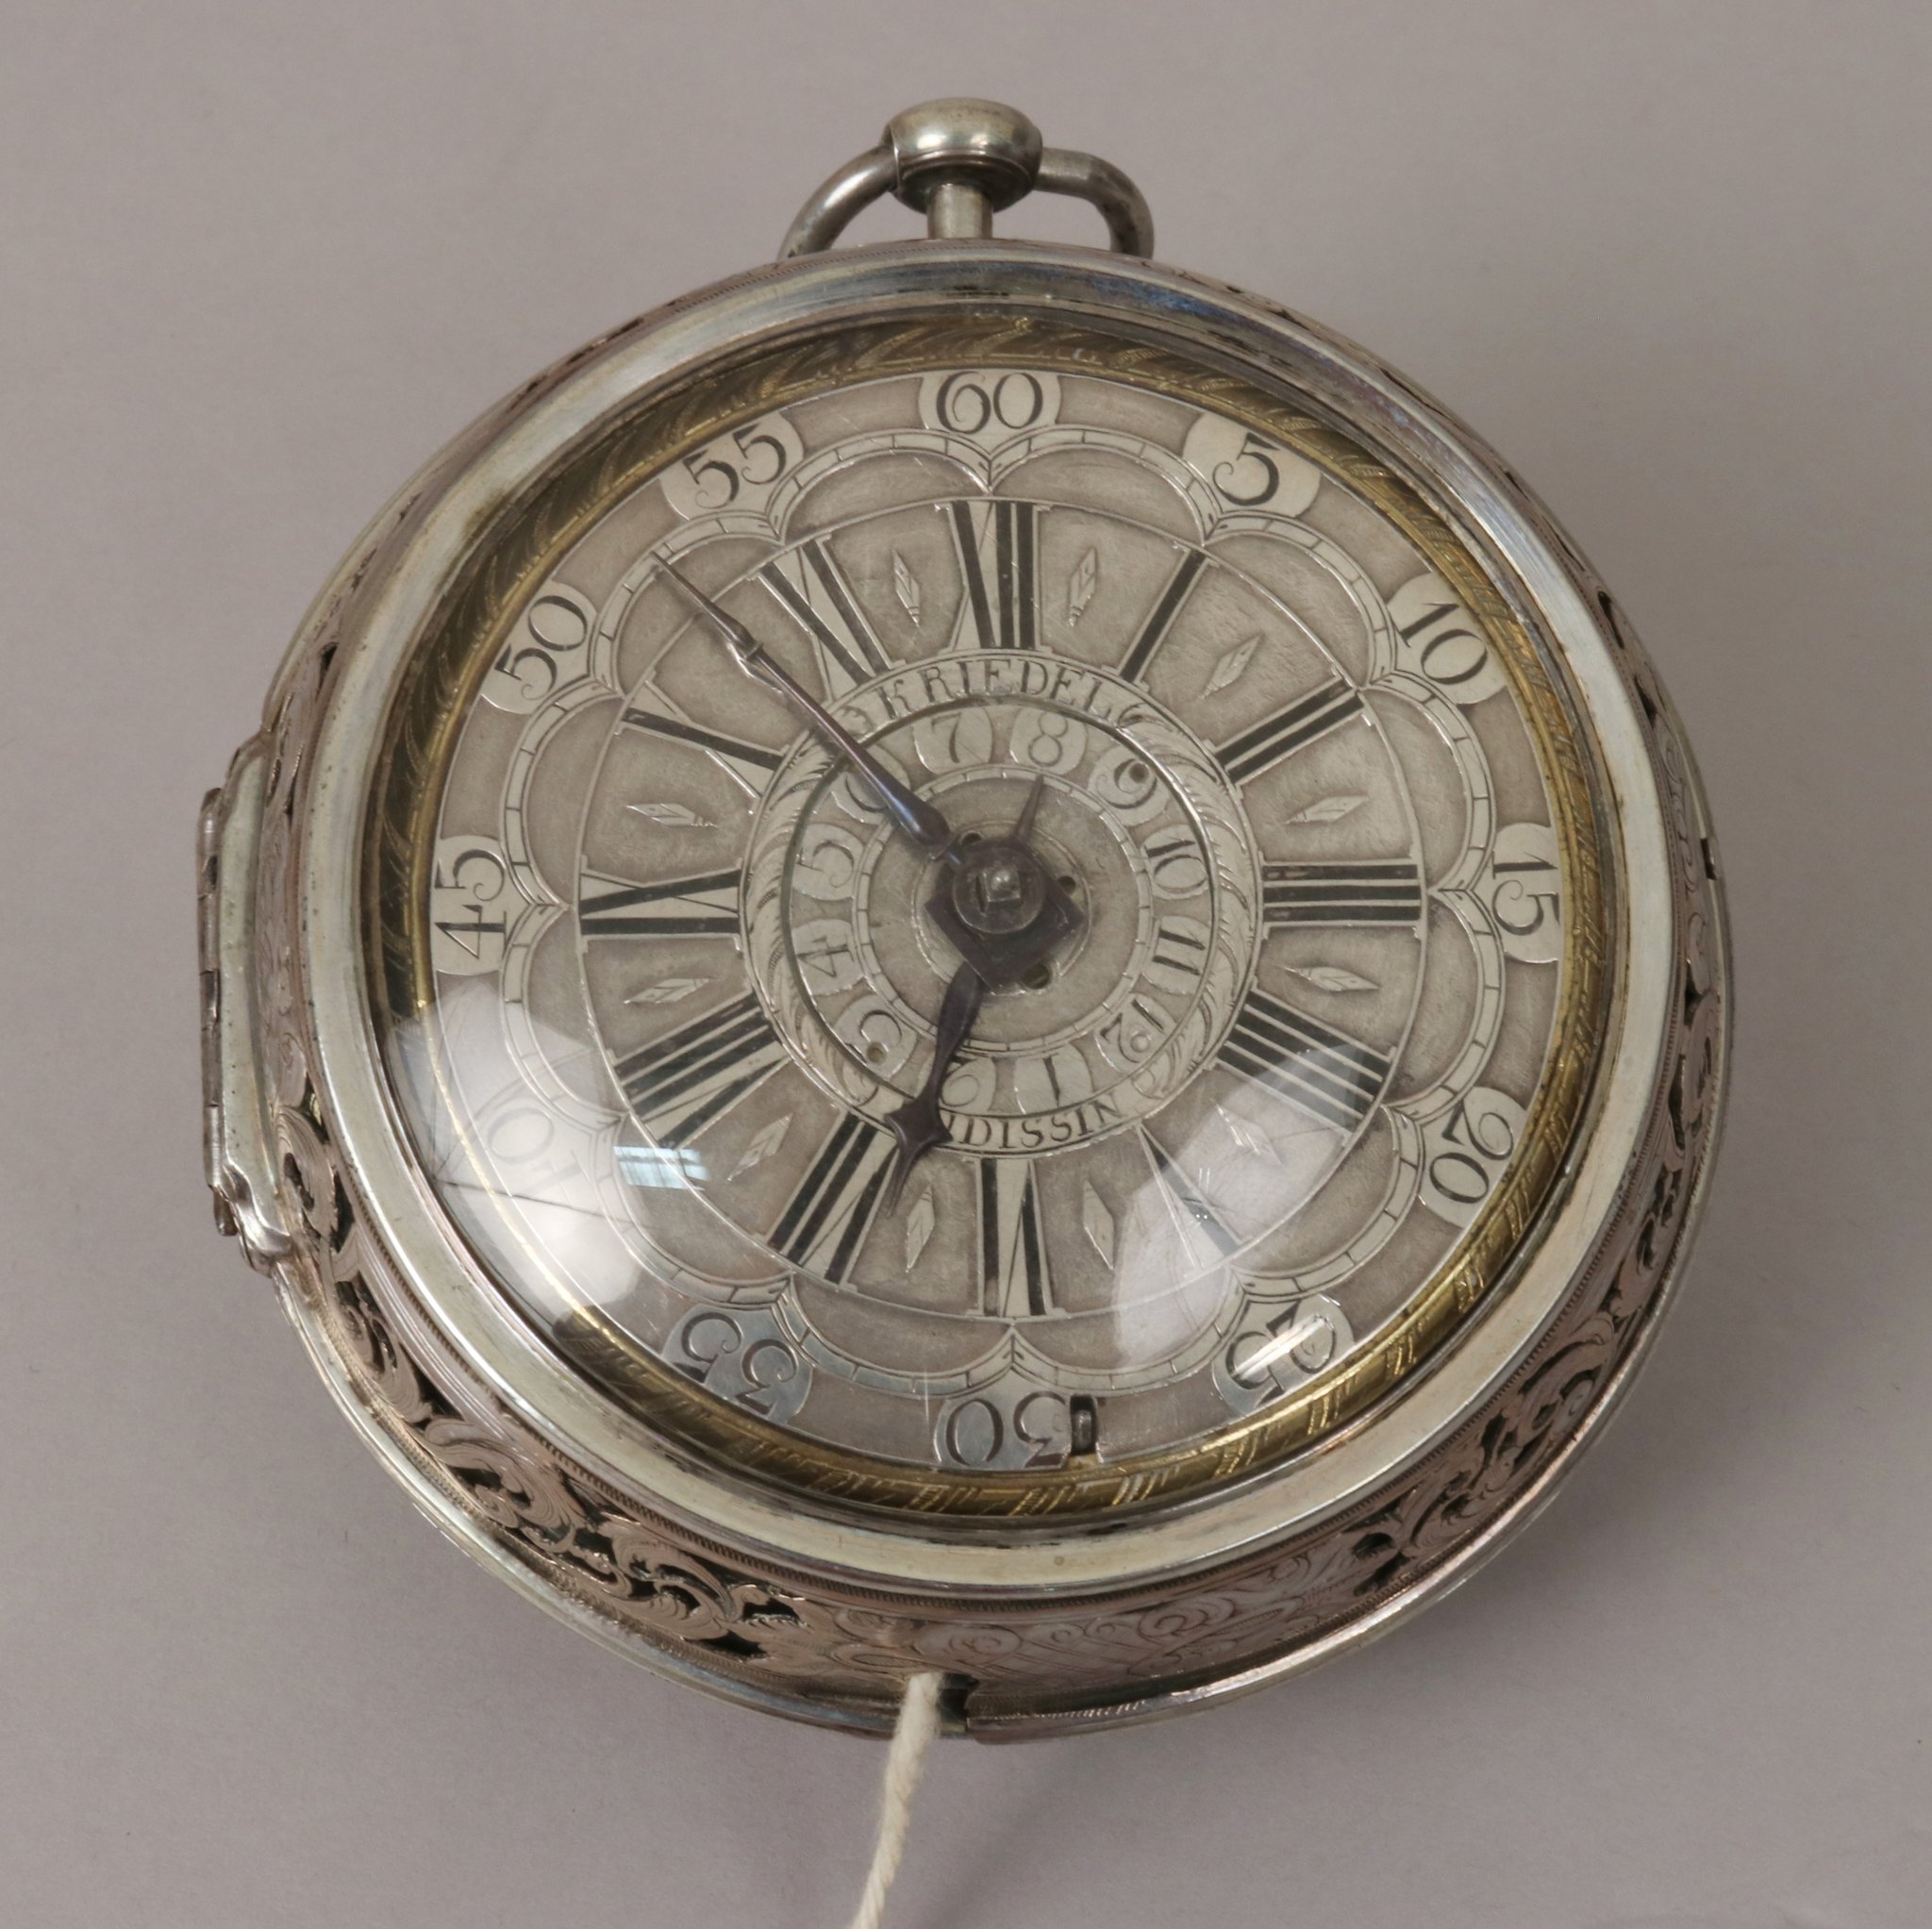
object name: clock watch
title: Travelling watch clock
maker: johann gottfried kriedel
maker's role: maker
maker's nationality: german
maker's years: 1702-1757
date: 1701-1733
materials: brass, silver, steel